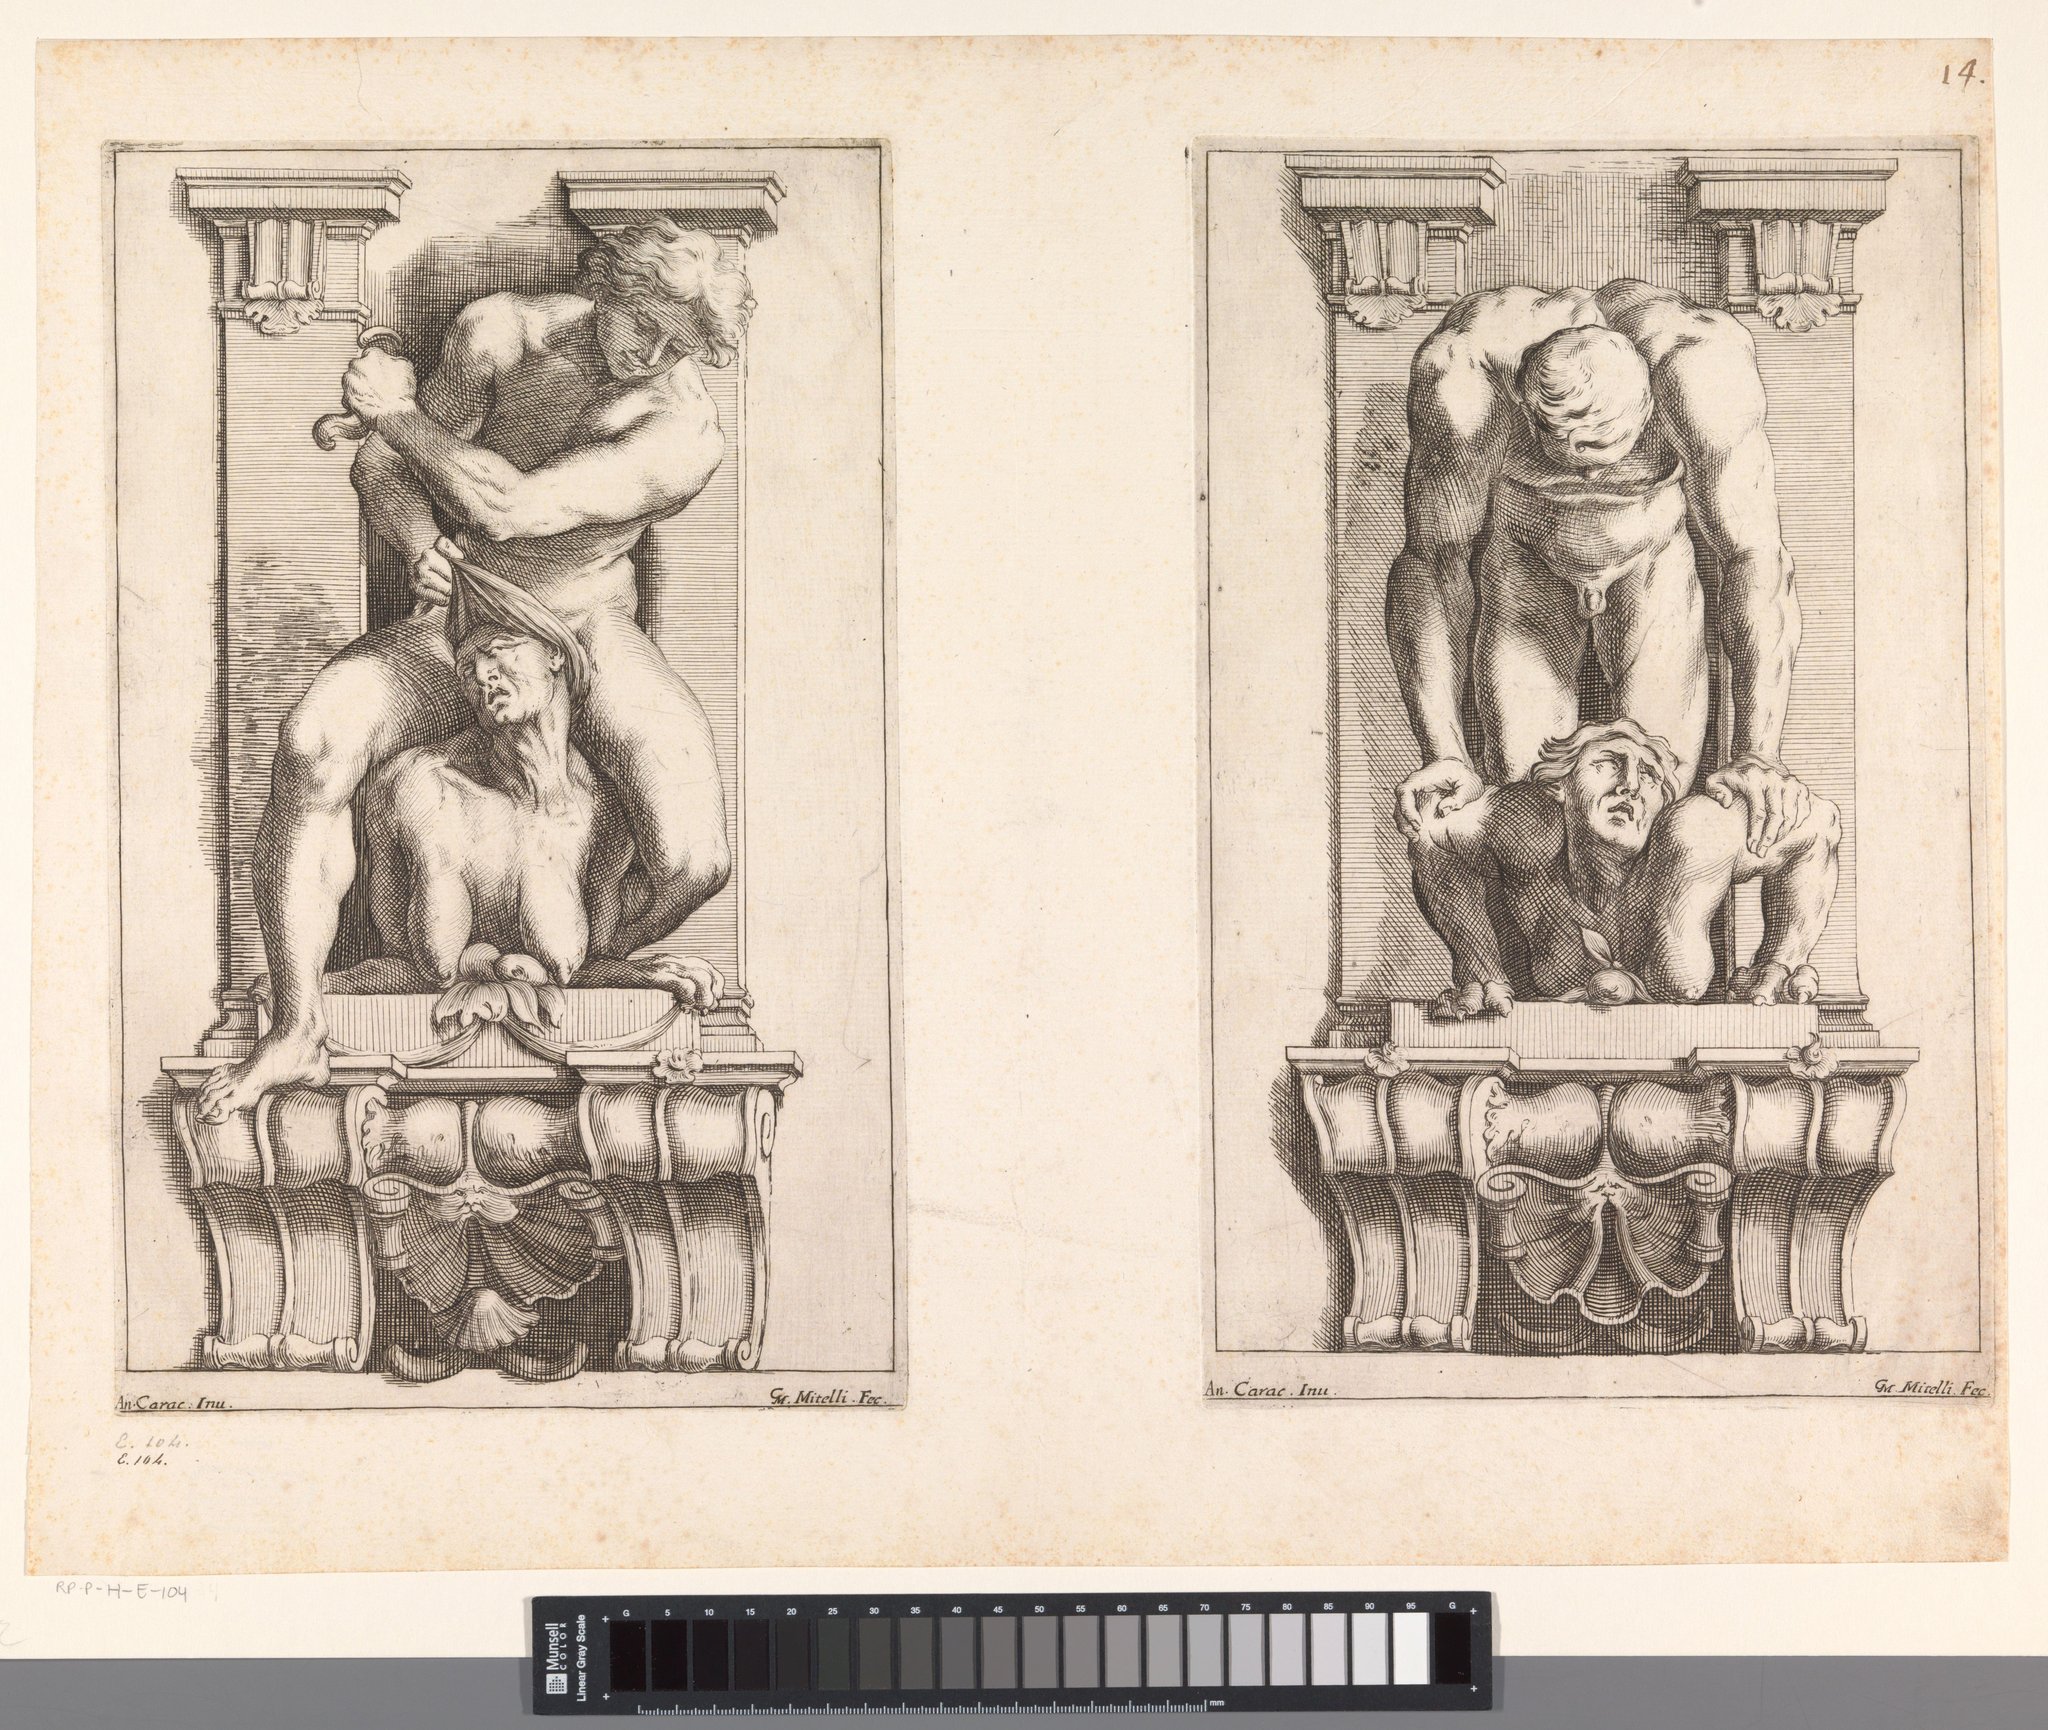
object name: print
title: Man onderwerpt een harpij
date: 1663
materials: paper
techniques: etching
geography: italy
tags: the (nude) human figure; 'corpo humano' (ripa), other architectural details (console), harpies (classical mythology)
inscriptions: collector's mark: ‘Hinloopen’, collector's mark: Lugt 11, number: ‘14.’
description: Deze prent maakt deel uit van een reeks van 20 prenten (+ titelprent) naar de fresco's door de Carracci's in Palazzo Fava Ghisilieri te Bologna. Deze prent maakte oorspronkelijk deel uit van liber nr. 22 van de Atlas van Rome, uit de collectie Hinloopen. In dit album waren een aantal prentreeksen naar bekende zeventiende eeuwse frescoseries bijeengebonden. In 1709 heeft Schijnvoet op last van de burgemeesters van Amsterdam de collectie herordend. De prenten uit liber 22 kwamen terrecht in Schijnvoet boek nr. 10. De laatst gedateerde reeks in het album is gedateerd 1691. Het album moet dus na deze datum gebonden zijn. De band is in de Rijksakademietijd uit elkaar gehaald. De marges van de prenten zijn bij het opbergen in het Rijksprentenkabinet vaak drastisch afgesneden. Van een aantal series waren de prenten teruggeslagen om in het album te passen. (Zie: Waals, Jan van der. De prentschat van Michiel Hinloopen. 's-Gravenhage: SDU uitgeverij, 1988, pp. 173-174.)